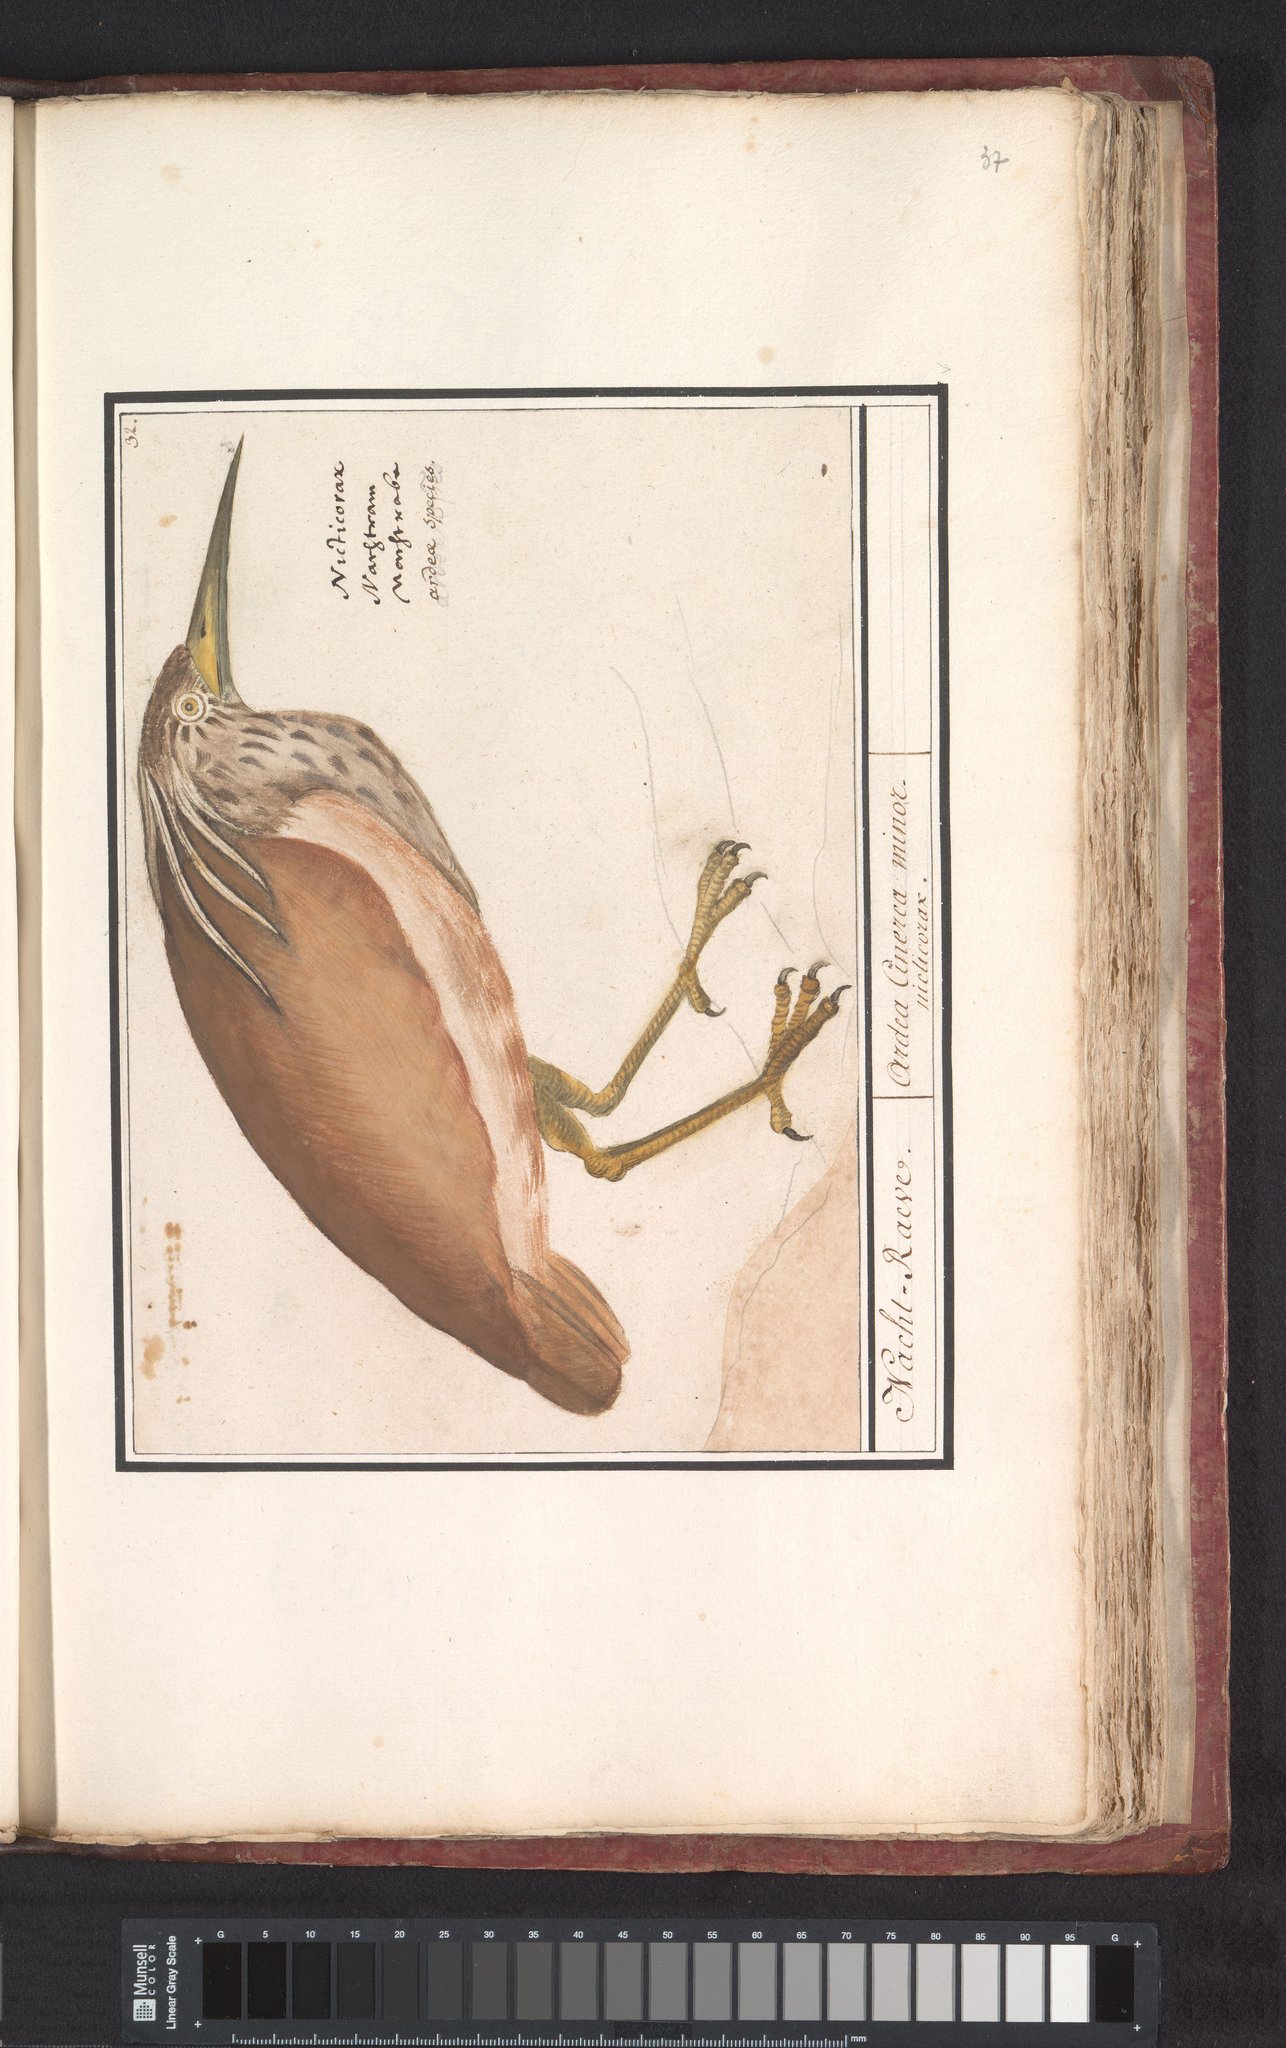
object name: drawing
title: Nacht-Raeve. / Ardea Cinerea minor. nicticorax.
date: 1596-1610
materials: chalk, paint, ink, paper, pencil, watercolor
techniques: brush, pen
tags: 25f37(squacco heron)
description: Ralreiger. Genummerd rechtsboven: 32. Met de naam in vier talen. Onderdeel van het derde album met tekeningen van vogels. Vijfde van twaalf albums met tekeningen van dieren, vogels en planten bekend rond 1600, gemaakt in opdracht van keizer Rudolf II. Met toelichting in Nederlands, Latijn en Frans.